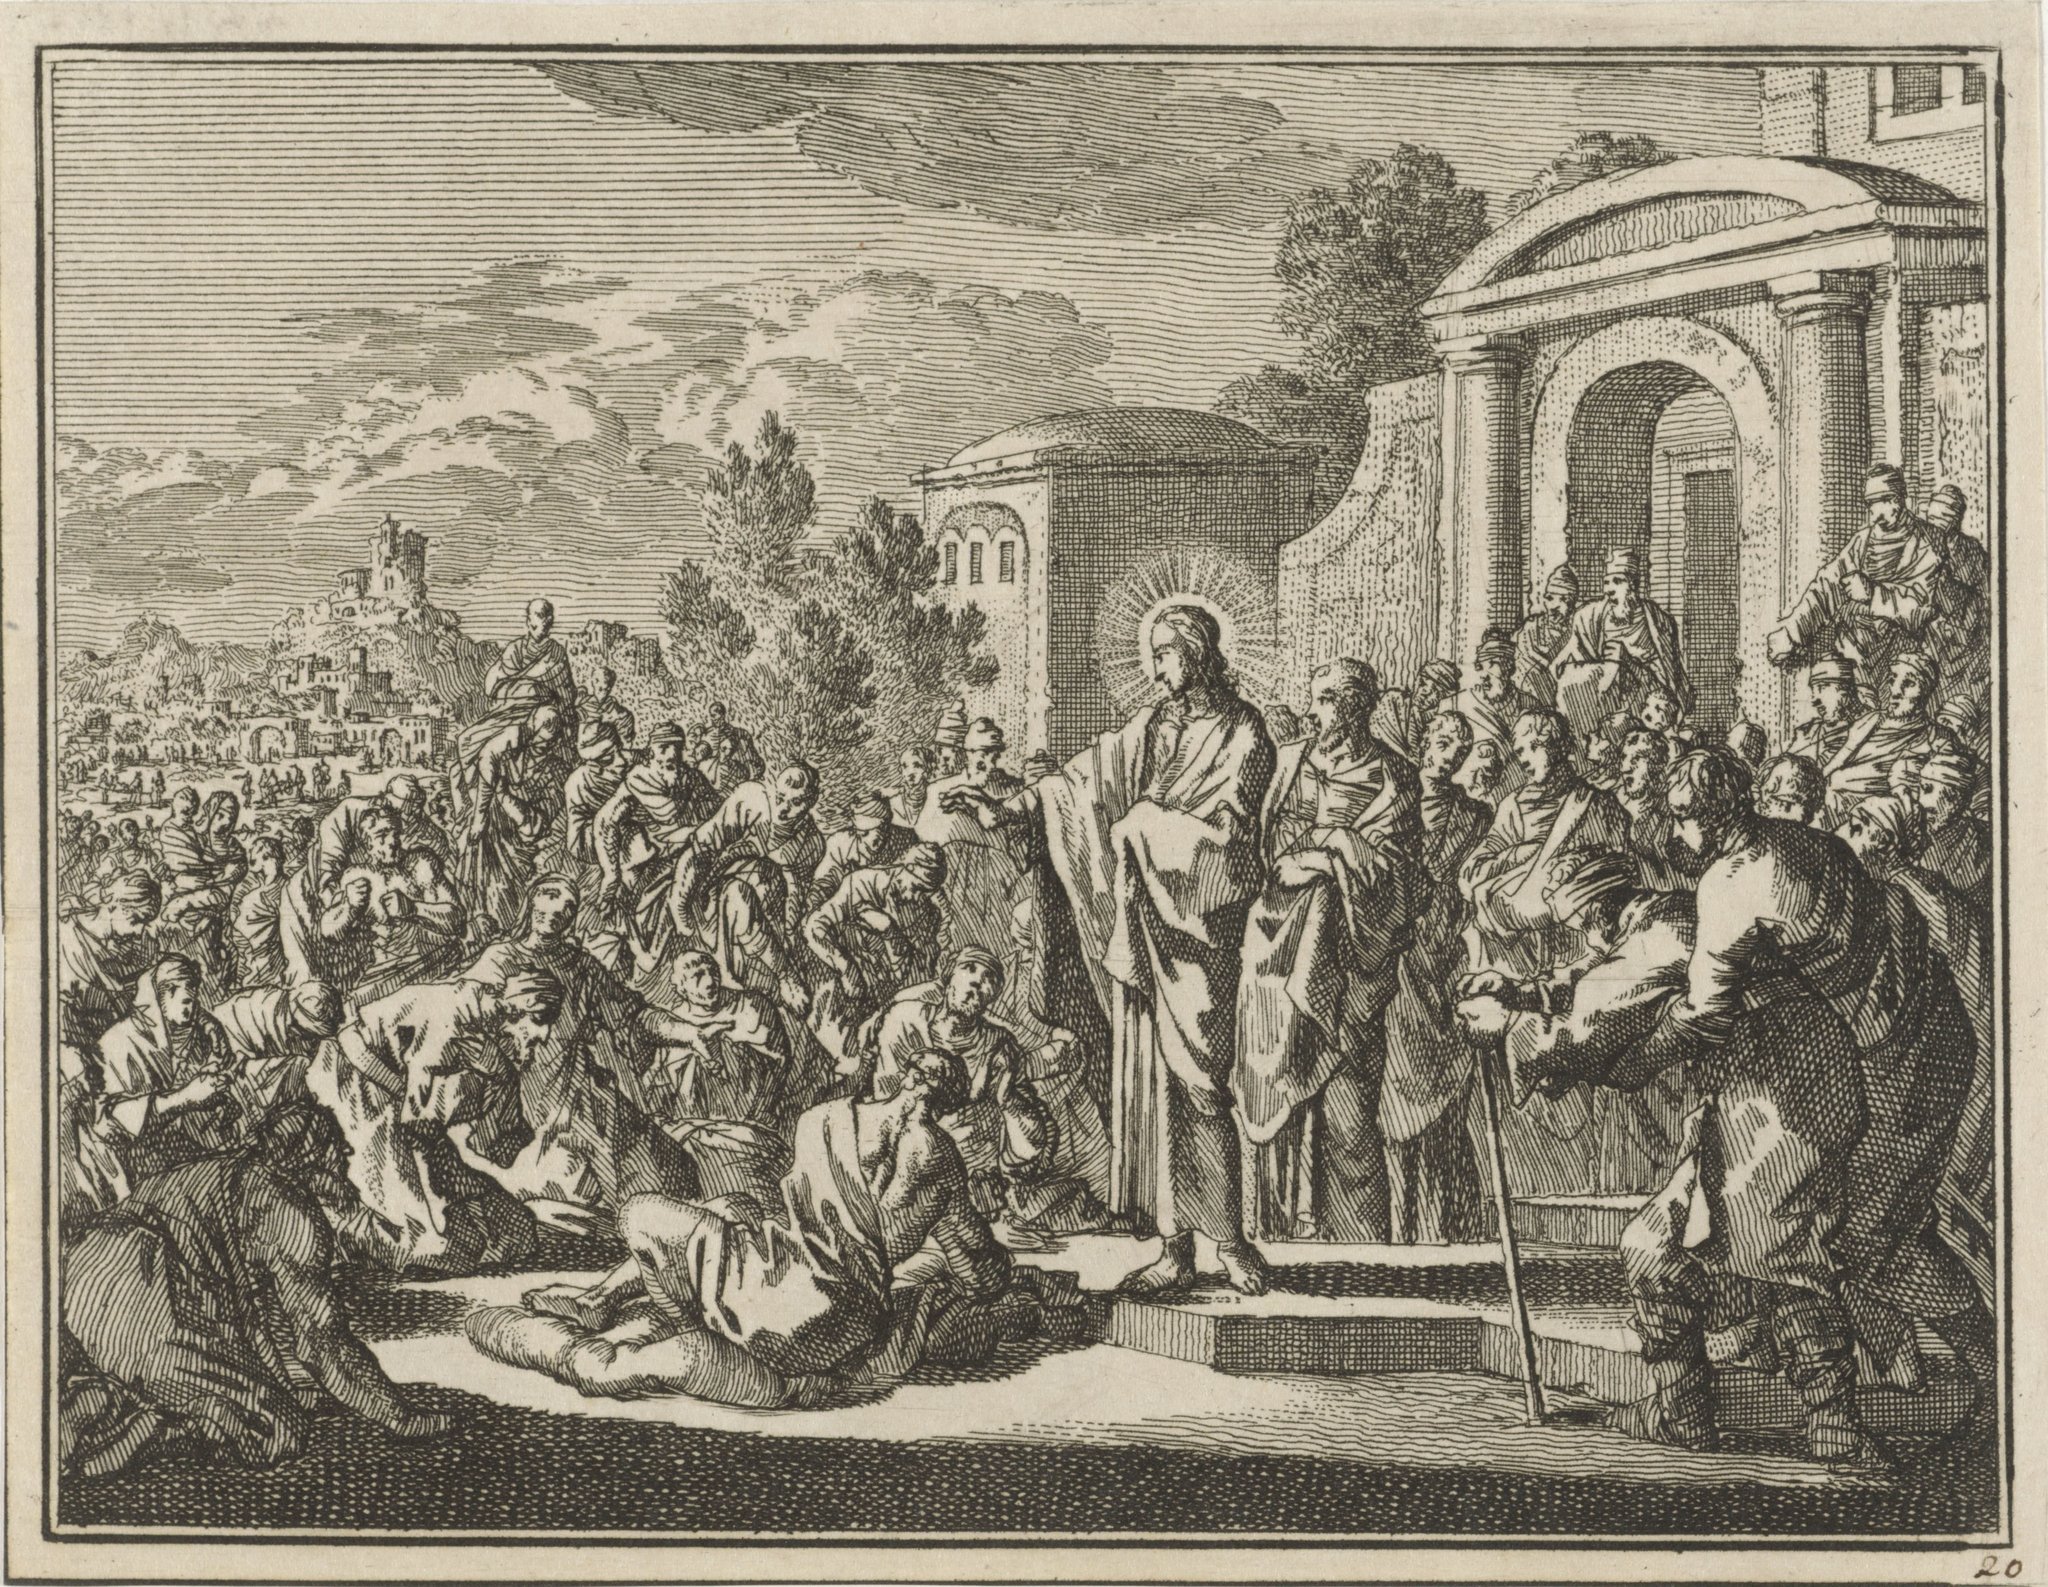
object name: print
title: Christus geneest de zieken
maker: jan luyken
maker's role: draughtsman, print maker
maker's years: 1649-1712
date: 1712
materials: paper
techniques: etching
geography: amsterdam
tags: miracles of christ ~ healing the sick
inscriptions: number: ‘20’, collector's mark: Lugt 2228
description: Proefdruk van illustratie uit: Luyken, Jan. De schriftuurlyke geschiedenissen en gelykenissen van het Oude en Nieuwe Verbond, 2 delen. Amsterdam: Wed. Pieter Arentsz II en Cornelis van der Sys, 1712, dl. II.